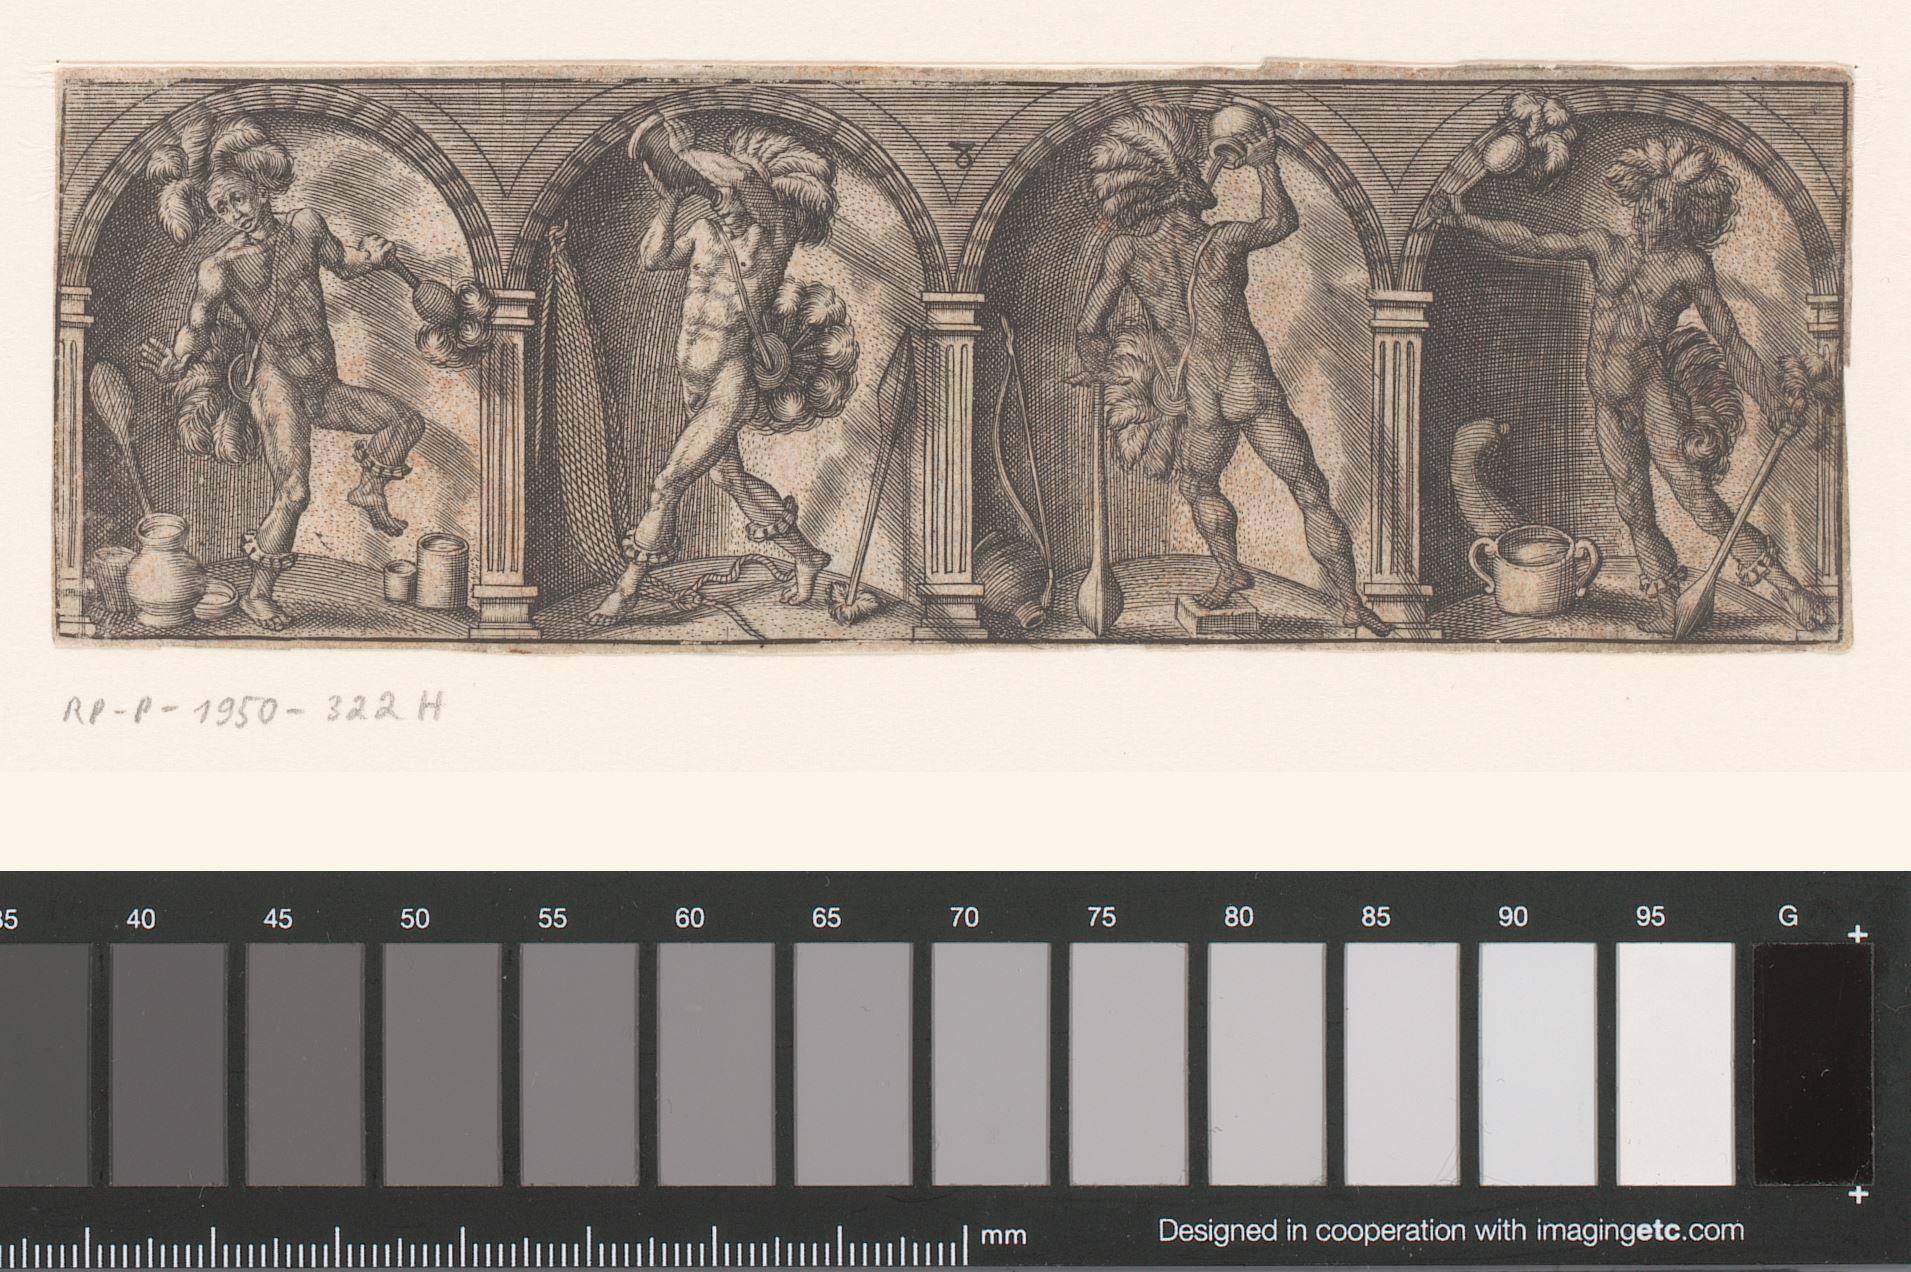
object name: print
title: Naakte man met verentooi in een niche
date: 1610-1640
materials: paper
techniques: engraving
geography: france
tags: parts of church interior: niche, man (showing himself) undressed, quasi-nude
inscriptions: collector's mark: Lugt 2228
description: In deze serie worden naakte figuren in vier architecturale niches geplaatst. Zij stellen de inwoners voor van de Nieuwe Wereld.